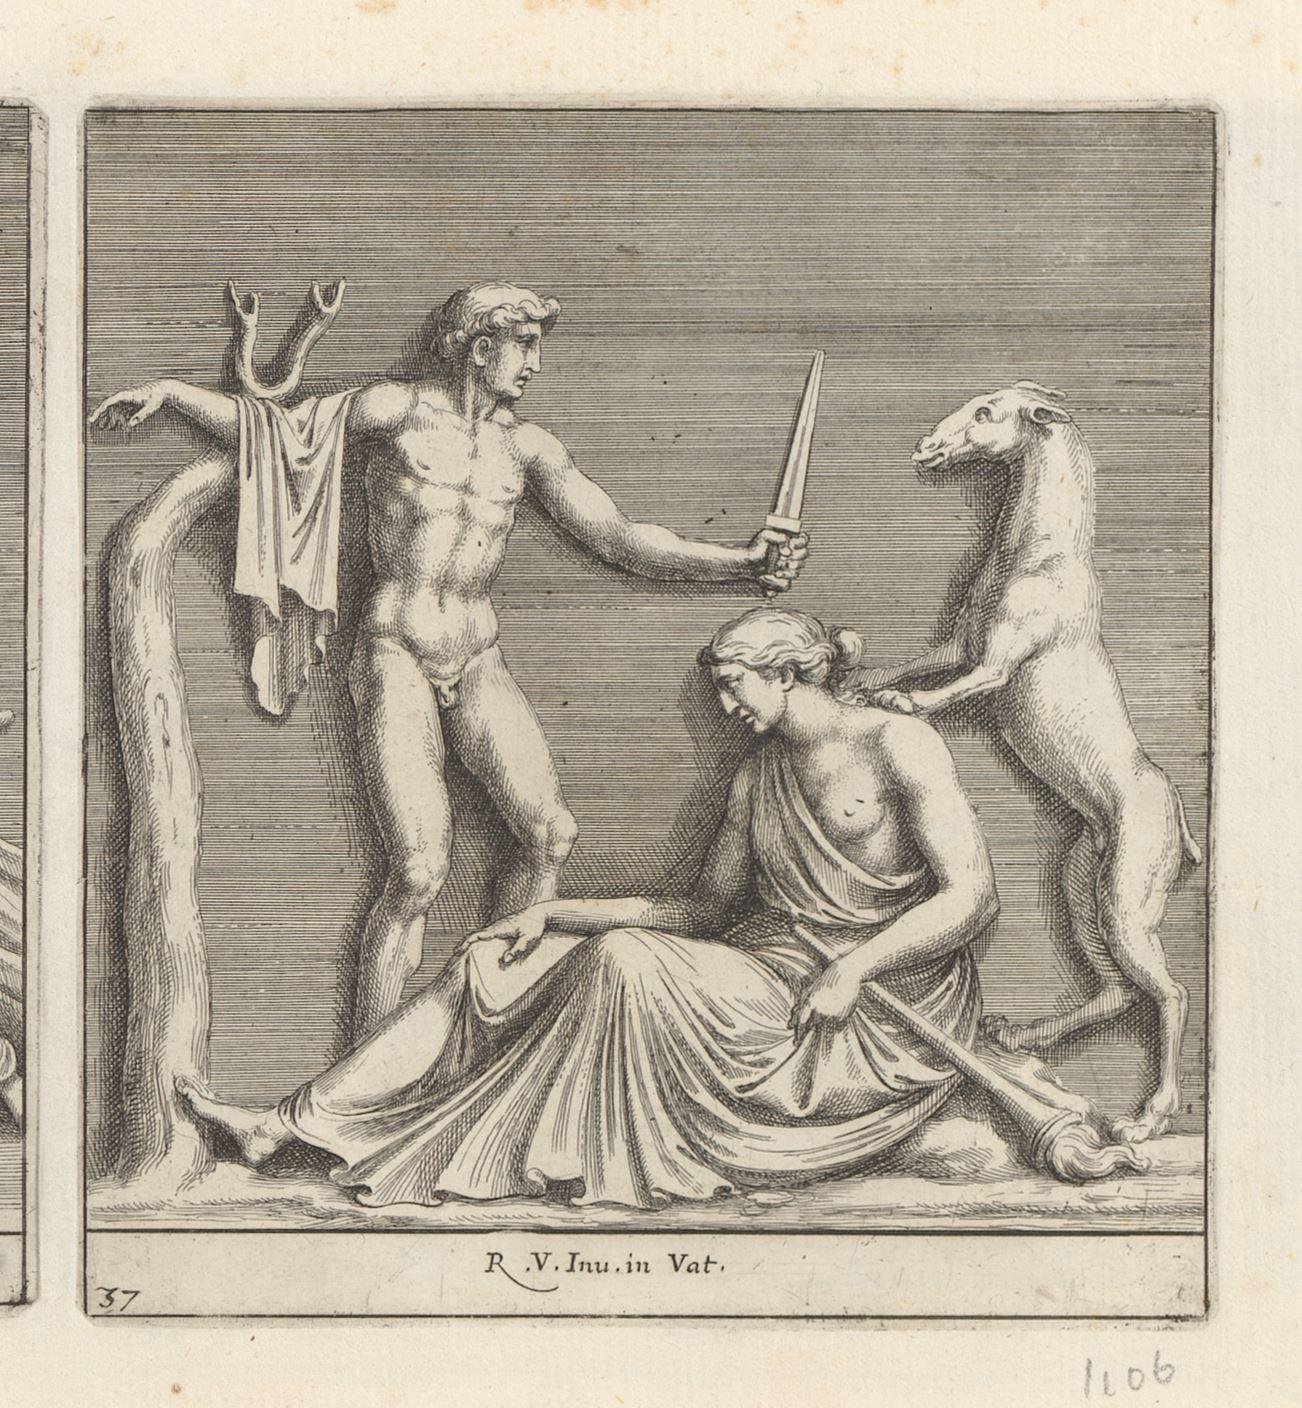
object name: album leaf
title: Reliëfs in de Loggia van Rafaël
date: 1645-1700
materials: paper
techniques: engraving, etching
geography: rome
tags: hacking and thrusting weapons: dagger, mis-shapen animals; monsters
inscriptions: number: ‘17’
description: Een man met een dolk (Orestes?) staat naast een zittende vrouw (een Erinyen?). Achter de vrouw staat een fantasiewezen. Prent maakt deel uit van een album.